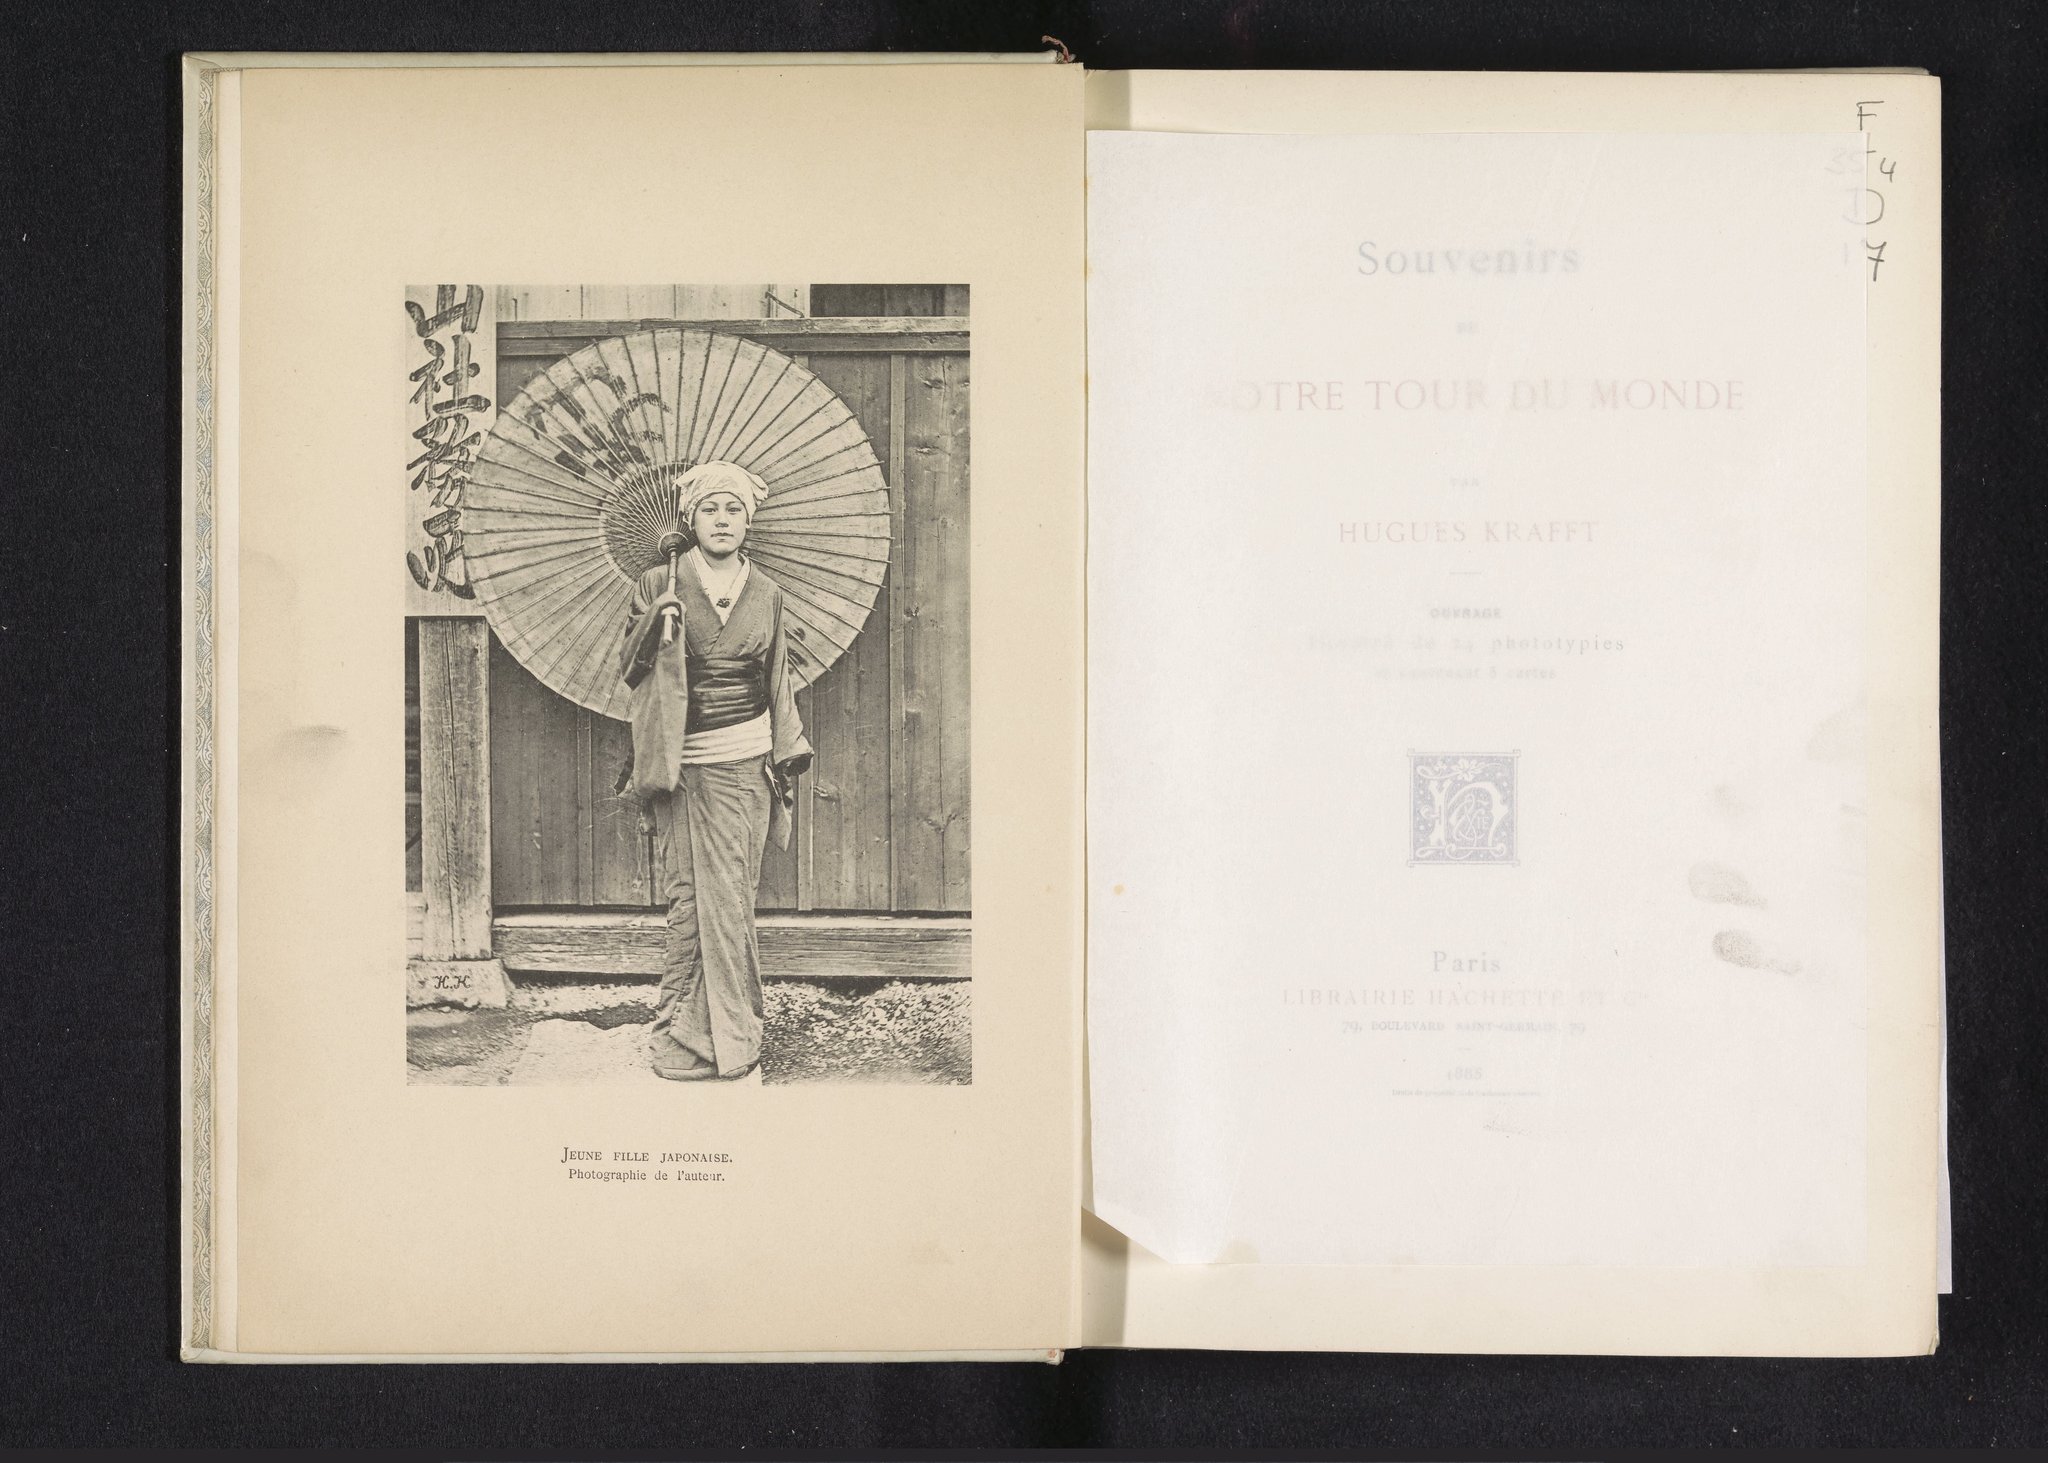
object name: page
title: Meisje met een parasol te Japan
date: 1882-1883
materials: paper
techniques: photograph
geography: japan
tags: child, folk costume, regional costume, parasol, sunshade, japan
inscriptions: inscription: ‘H. K.’, inscription: ‘Photographie de l'auteur.’